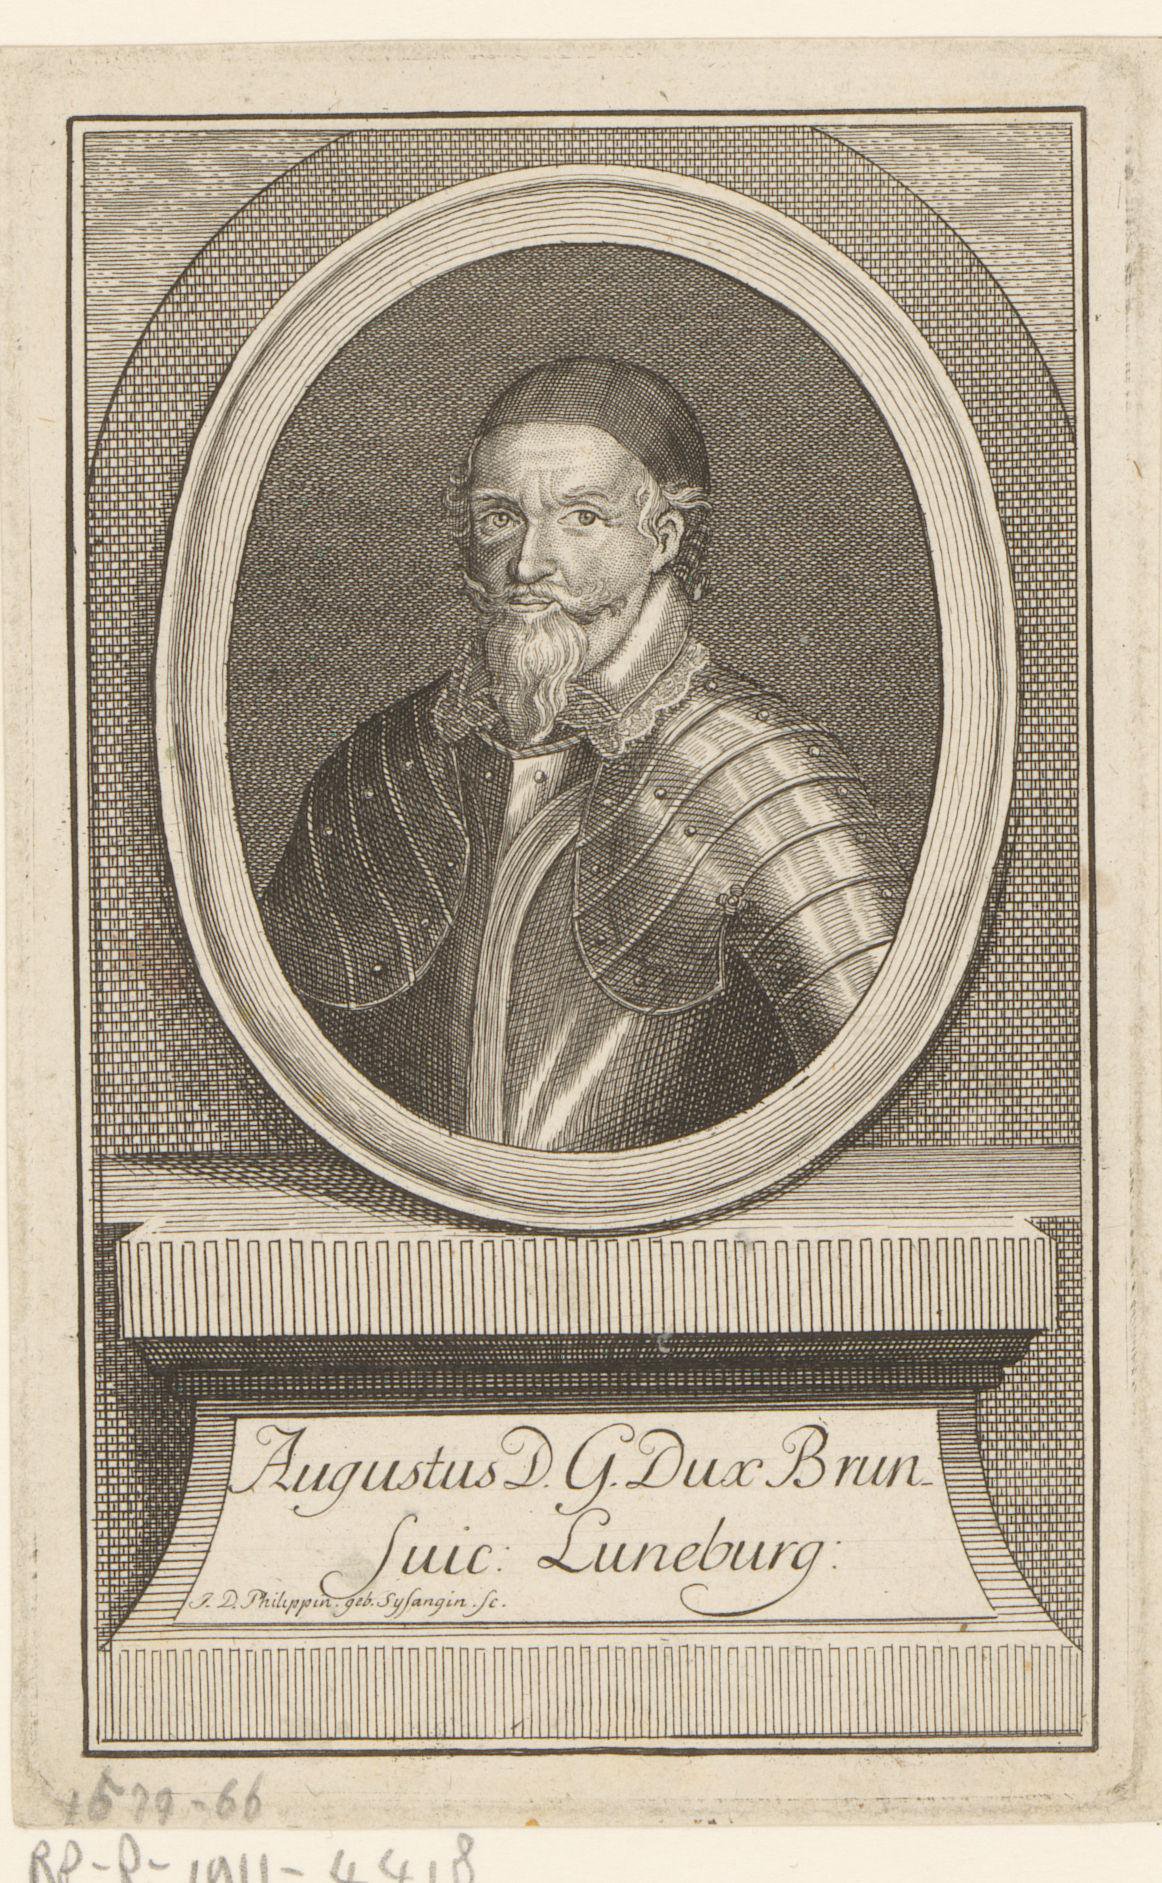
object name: print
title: Portret van August II de Jongere, hertog van Braunschweig-Lüneburg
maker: johanna dorothea sysang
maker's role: print maker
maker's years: 1729-1791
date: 1739-1791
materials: paper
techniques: engraving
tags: august von braunschweig-lüneburg (hertog van braunschweig-wolfenbüttel), armour, historical persons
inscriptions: collector's mark: Lugt 2228, date